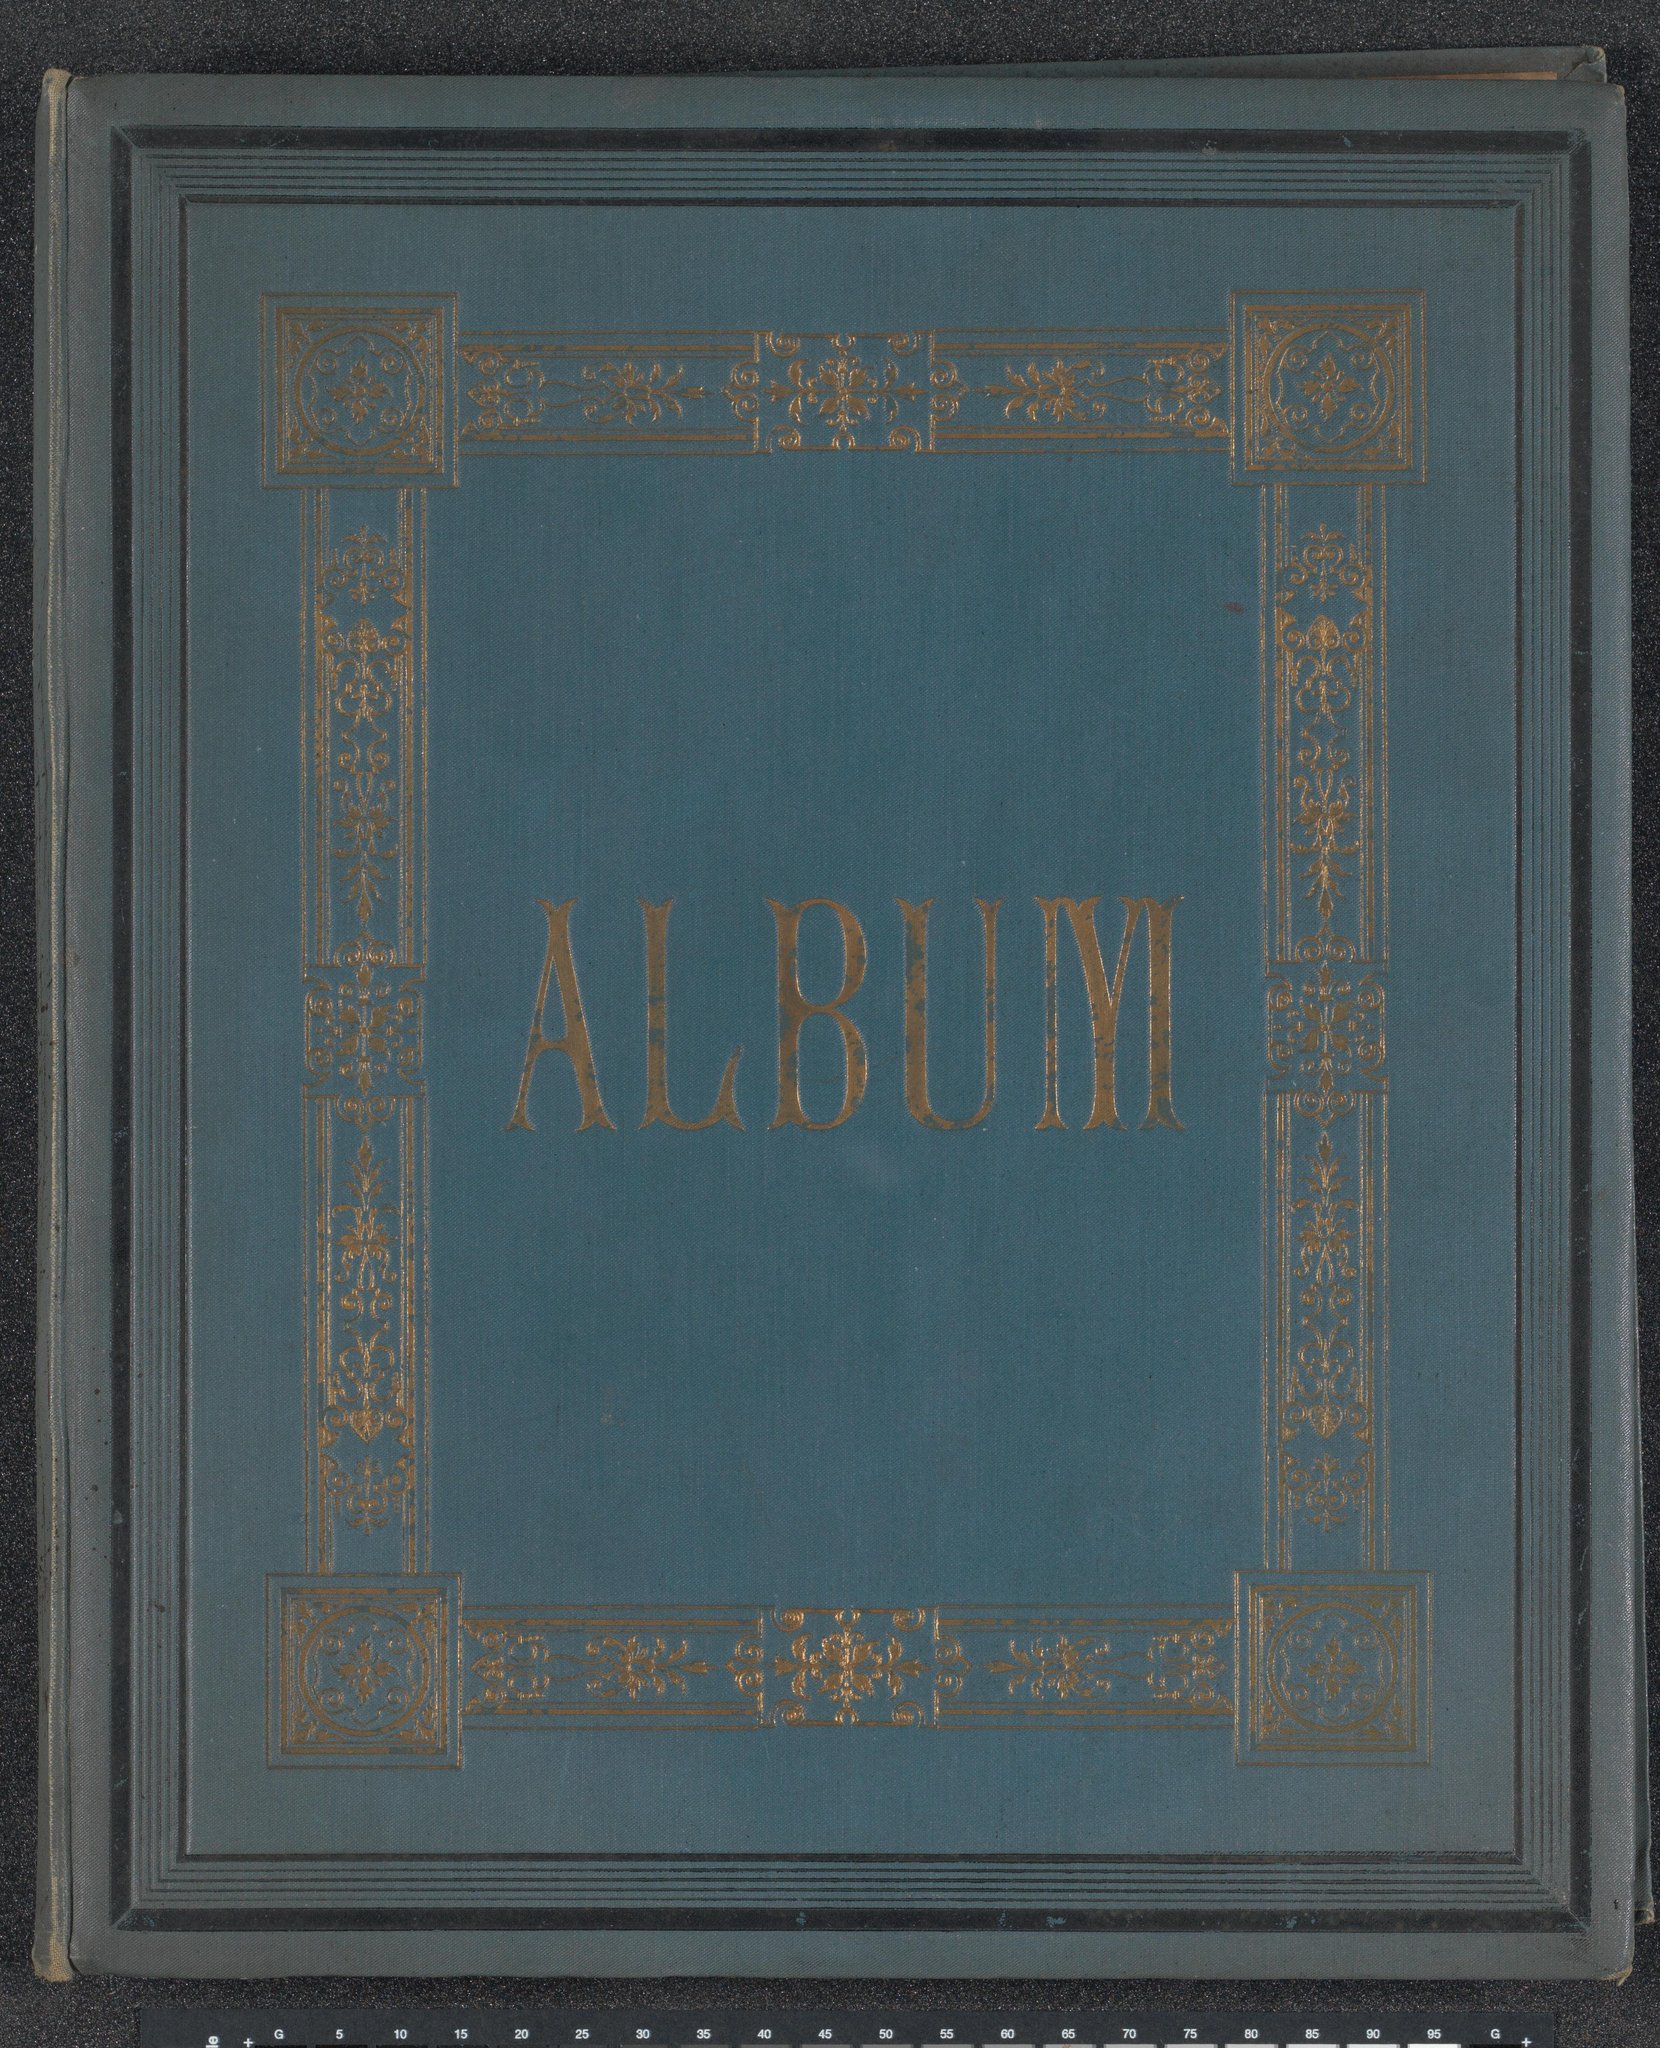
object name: photograph album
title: Reisalbum met foto's van bezienswaardigheden in Duitsland en Oostenrijk en van kunstwerken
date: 1870-1900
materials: cardboard, linen, paper, photographic support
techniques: albumen print, photograph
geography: zierikzee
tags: art, travelling; tourism, germany, austria, vienna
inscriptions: inscription: ‘A.M.E. van Dishoeck Boekhandel Zierikzee’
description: Fotoalbum in blauwgrijze linnen band met op het voorplat het woord 'Album' in gouddruk. De voorzijde is versierd met kaders, de binnenste heeft een plantenmotief in gouddruk. Het album bevat 32 bladen met 46 foto's. Het zijn voornamelijk opnames van gebouwen, monumenten en standbeelden in München, Neurenberg, Salzburg en Wenen en van berglandschappen in Oostenrijk. Voorts bevat het album fotoreproducties van kunstwerken door Titiaan, Rafael, Rembrandt, Peter Paul Rubens, Anthony van Dyck en Murillo.